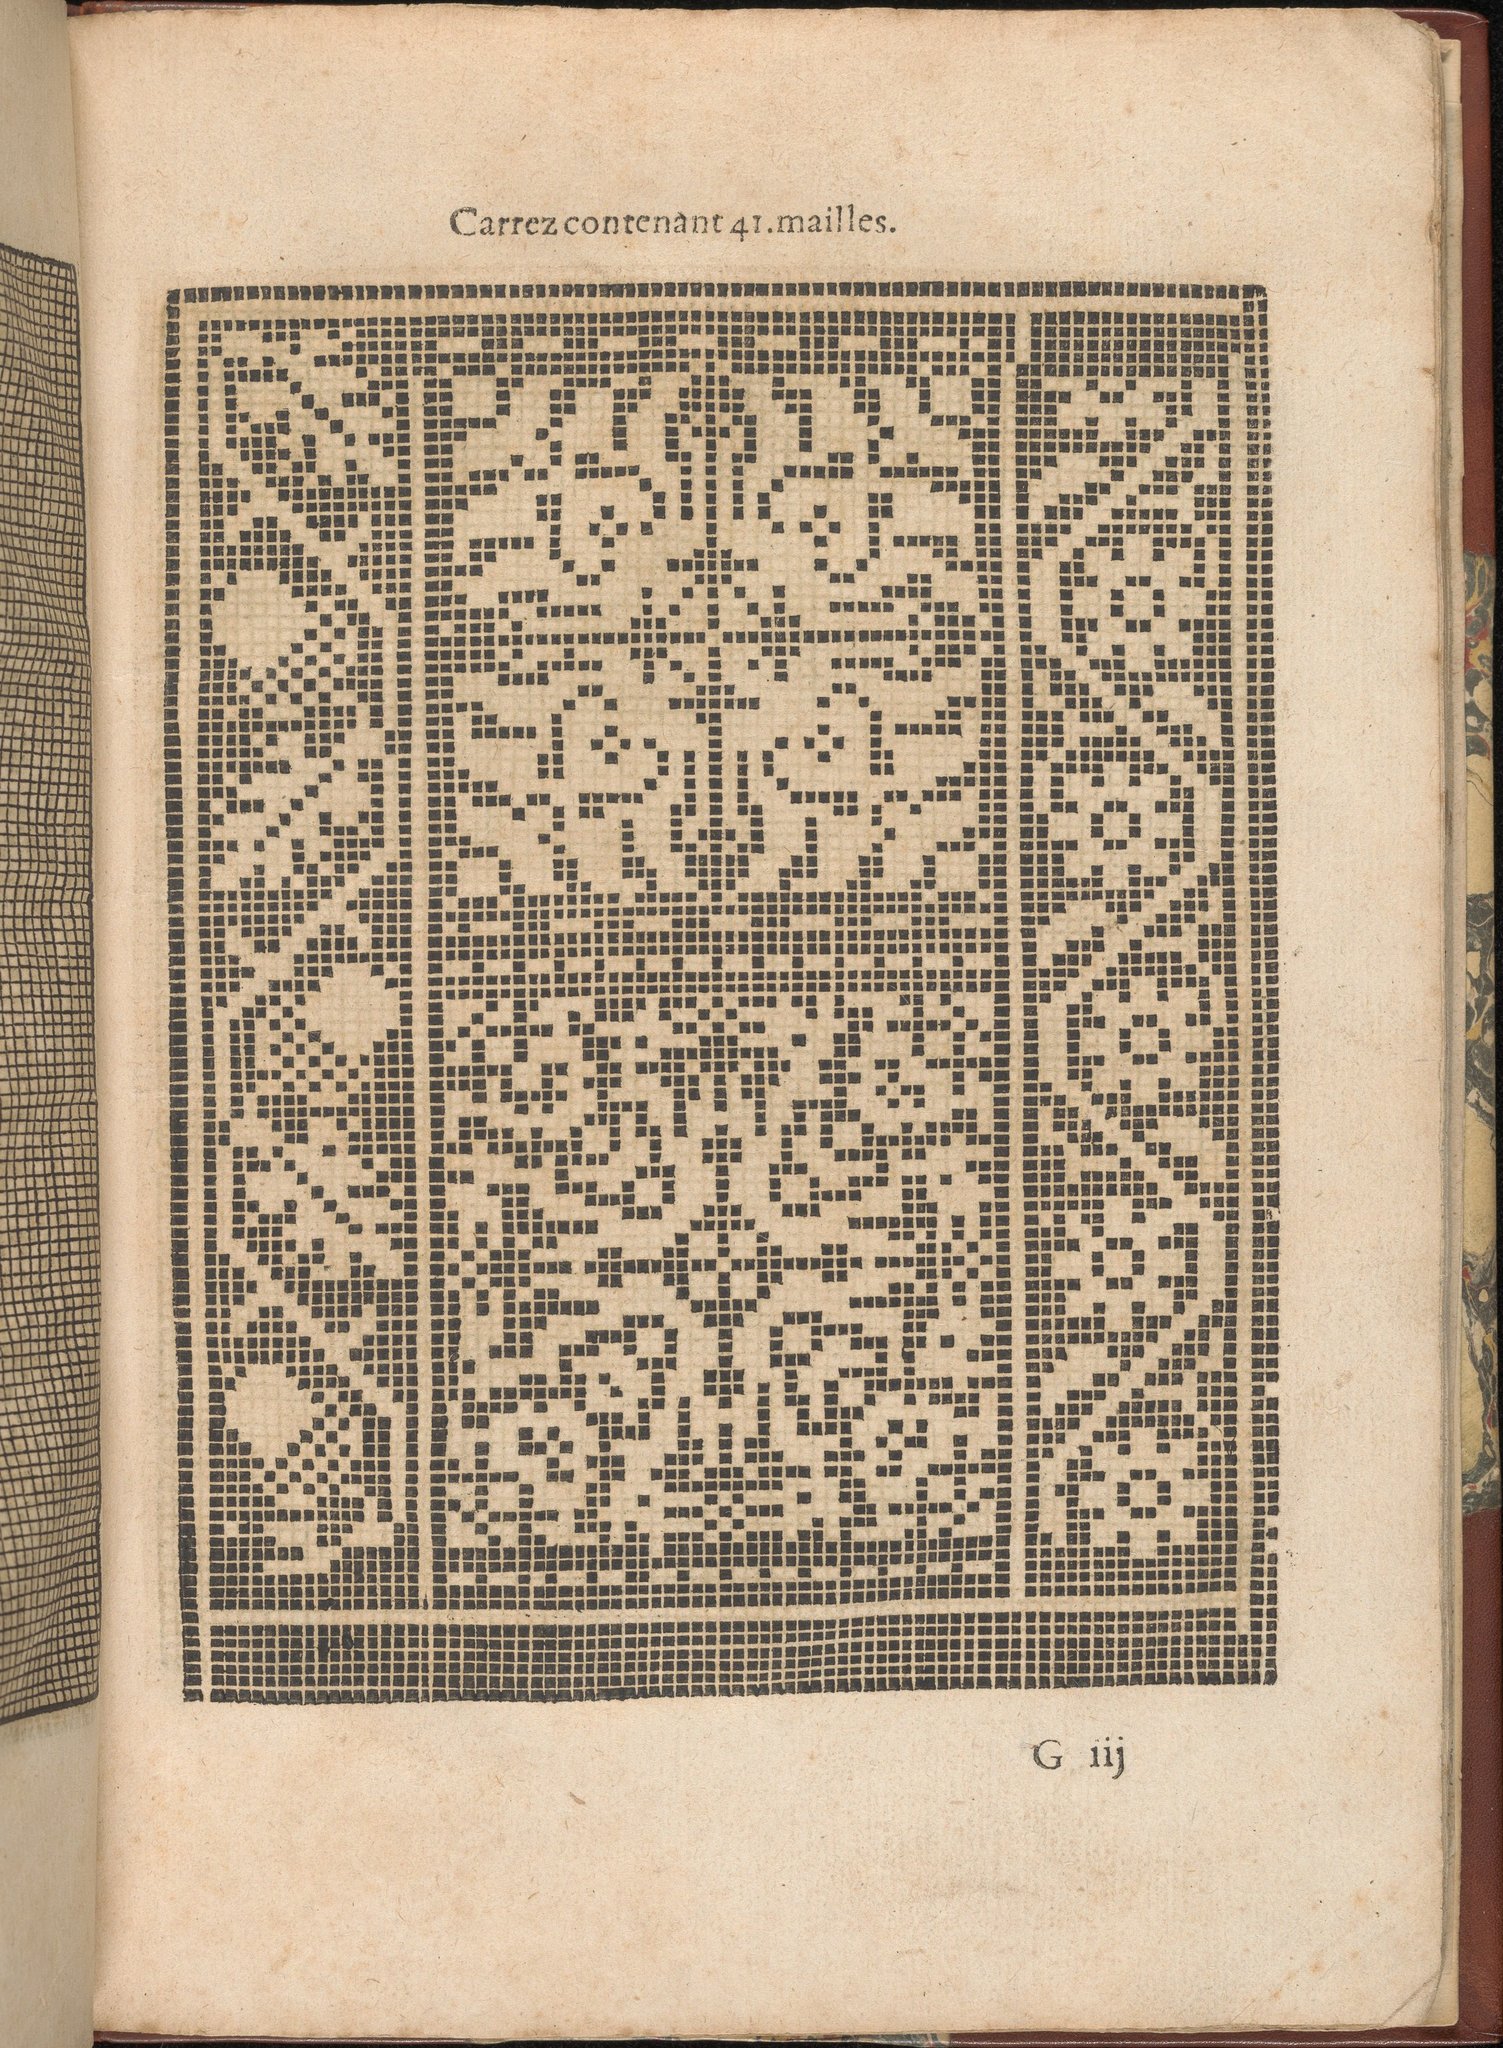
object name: book print ornament architecture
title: Les Secondes Oeuvres, et Subtiles Inventions De Lingerie du Seigneur Federic de Vinciolo Venitien, page 27 (recto)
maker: federico de vinciolo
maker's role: designer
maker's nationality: italian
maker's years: 1582-1599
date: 1603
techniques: woodcut